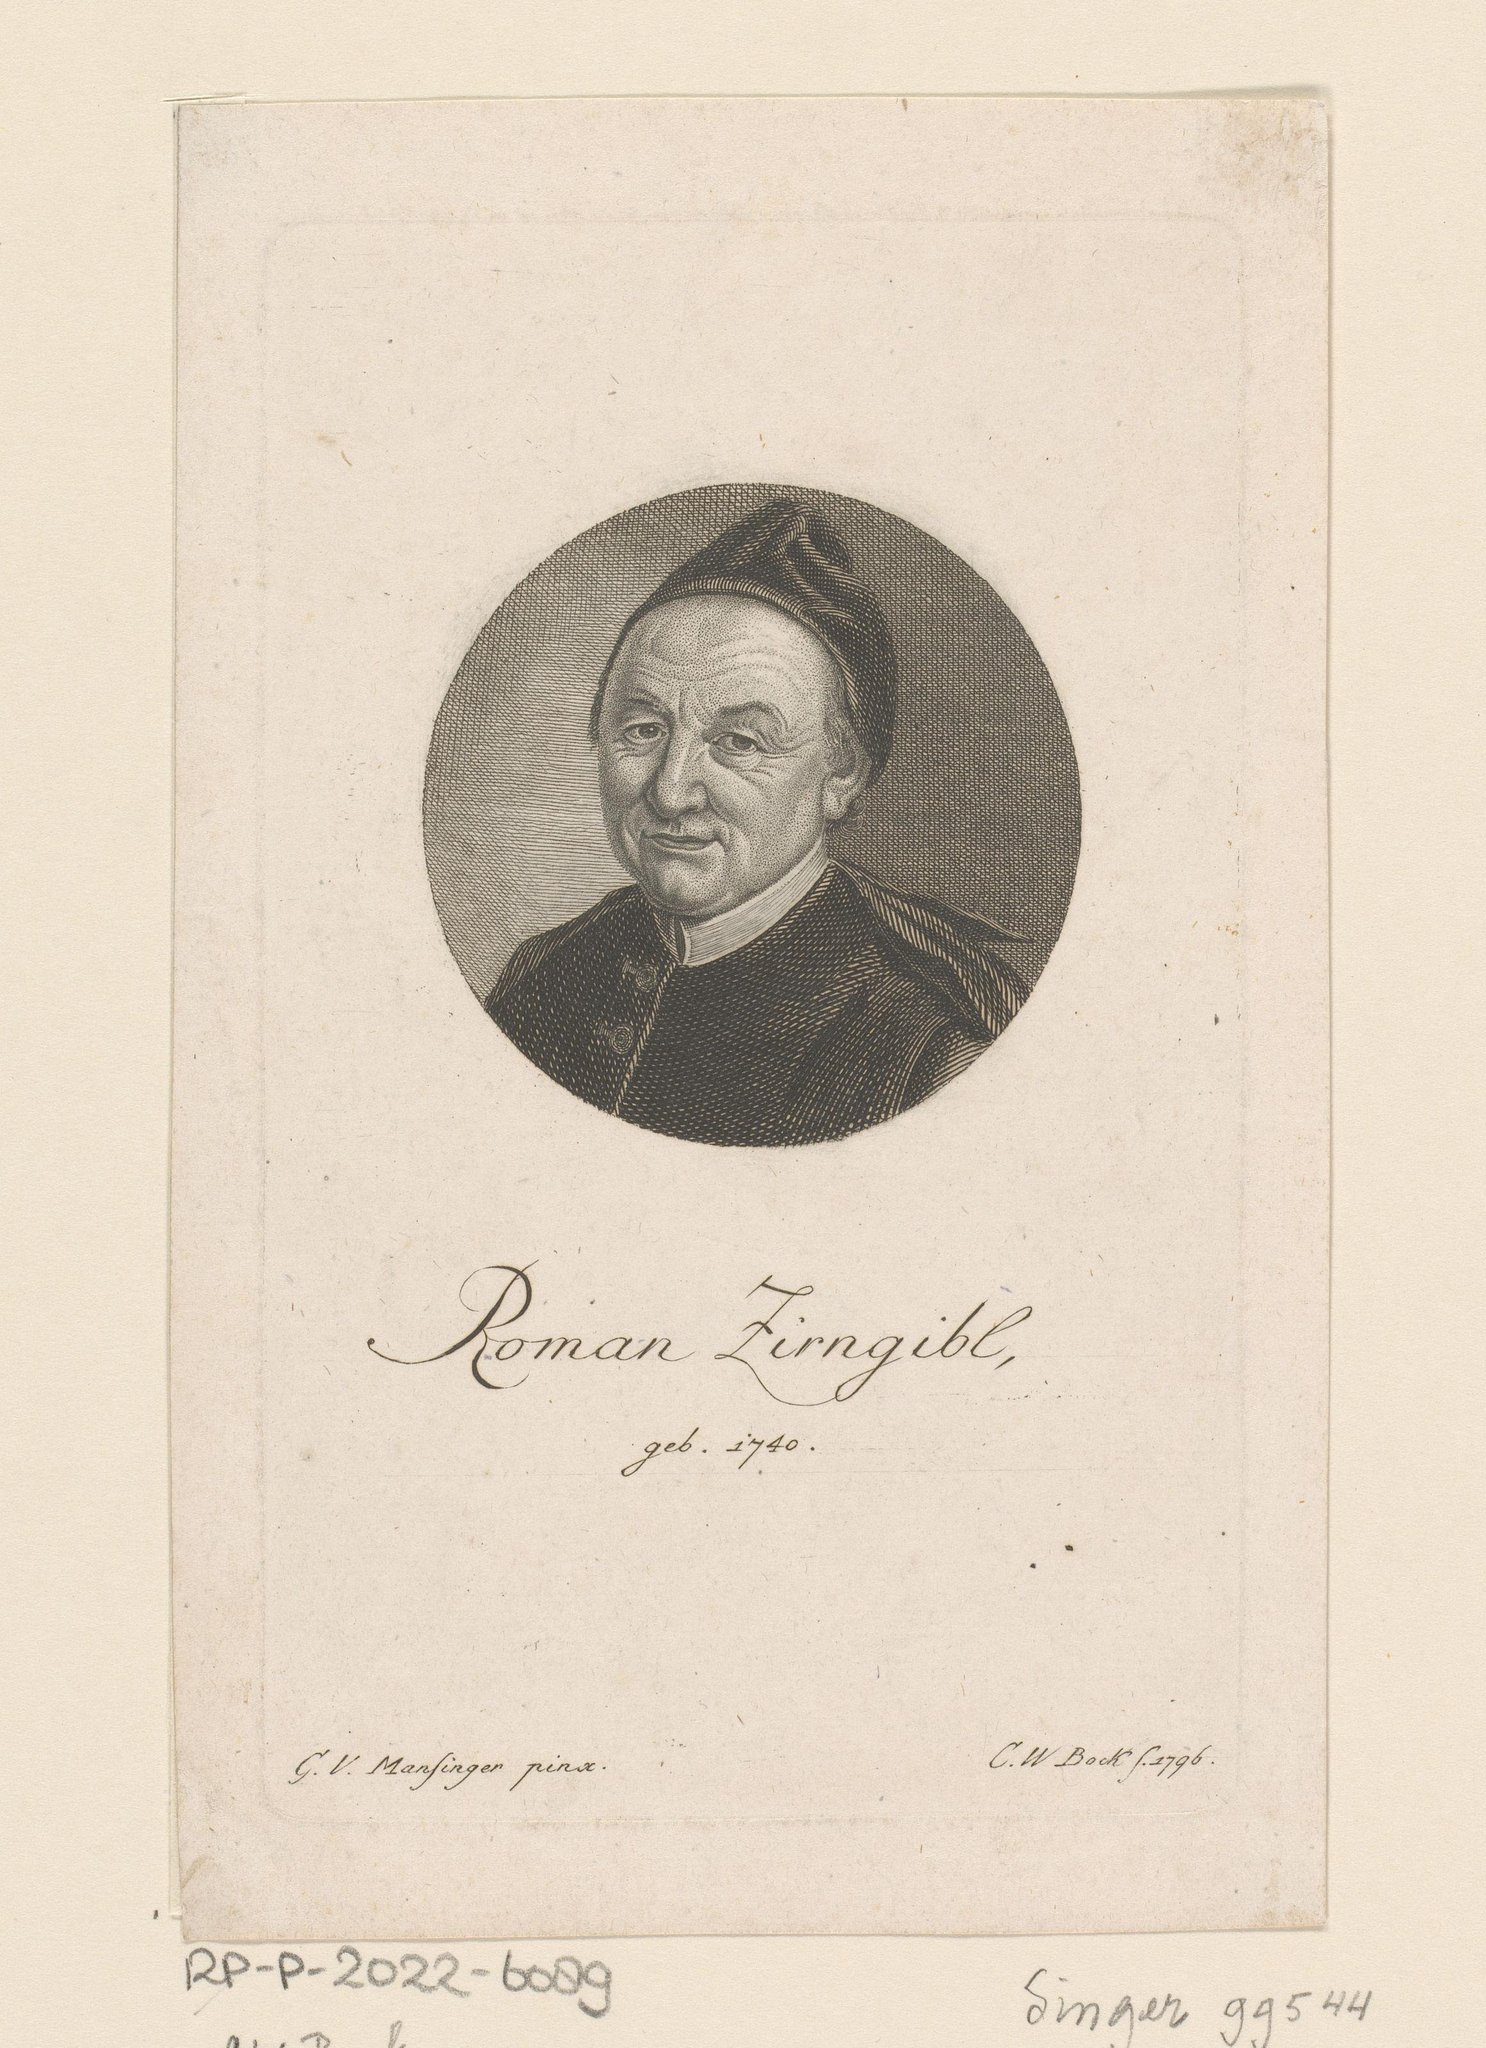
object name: print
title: Portret van Roman Zirngibl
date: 1796-1797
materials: paper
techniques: engraving, etching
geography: nuremberg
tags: theologian, historical persons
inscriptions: collector's mark: Lugt 2228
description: Prent waarschijnlijk uit: Roman Zirngibl Benediktiner im Fürstl. Reichsstifte St. Emmeram. S.l.: s.n., 1797.